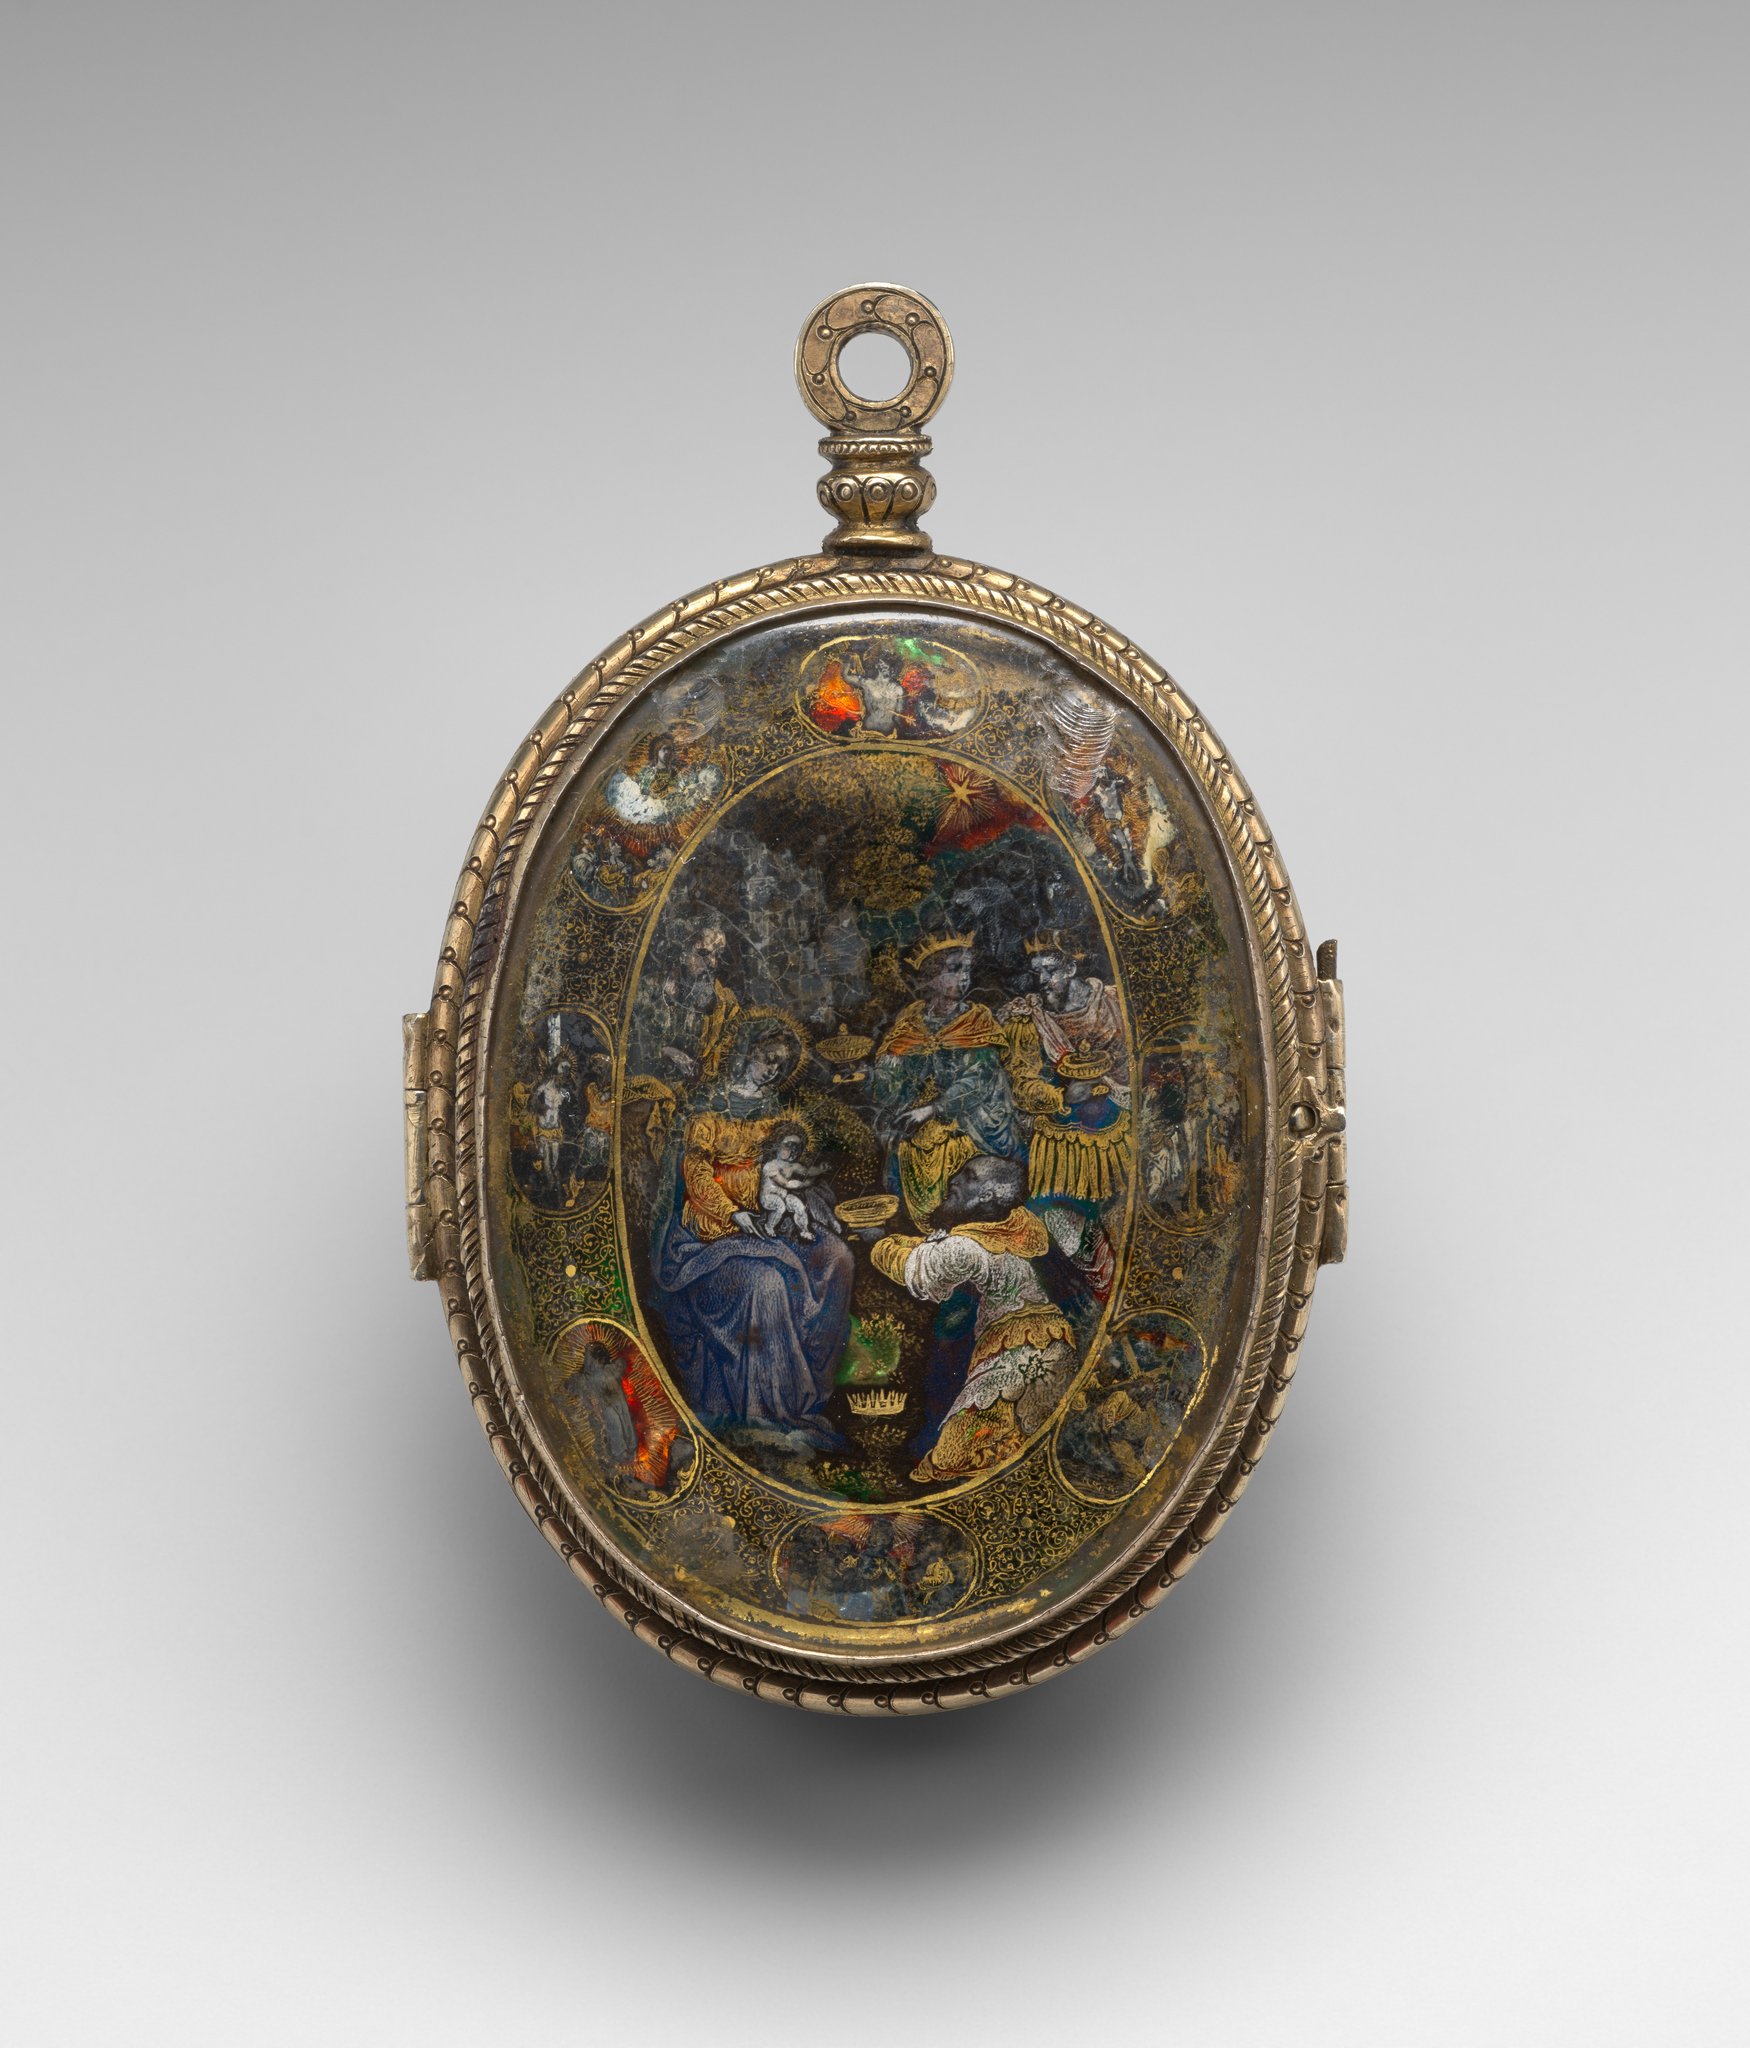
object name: reliquary pendant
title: Pendant reliquary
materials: quartz, silver gilt, parchment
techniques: painting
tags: jesus,adoration of the magi